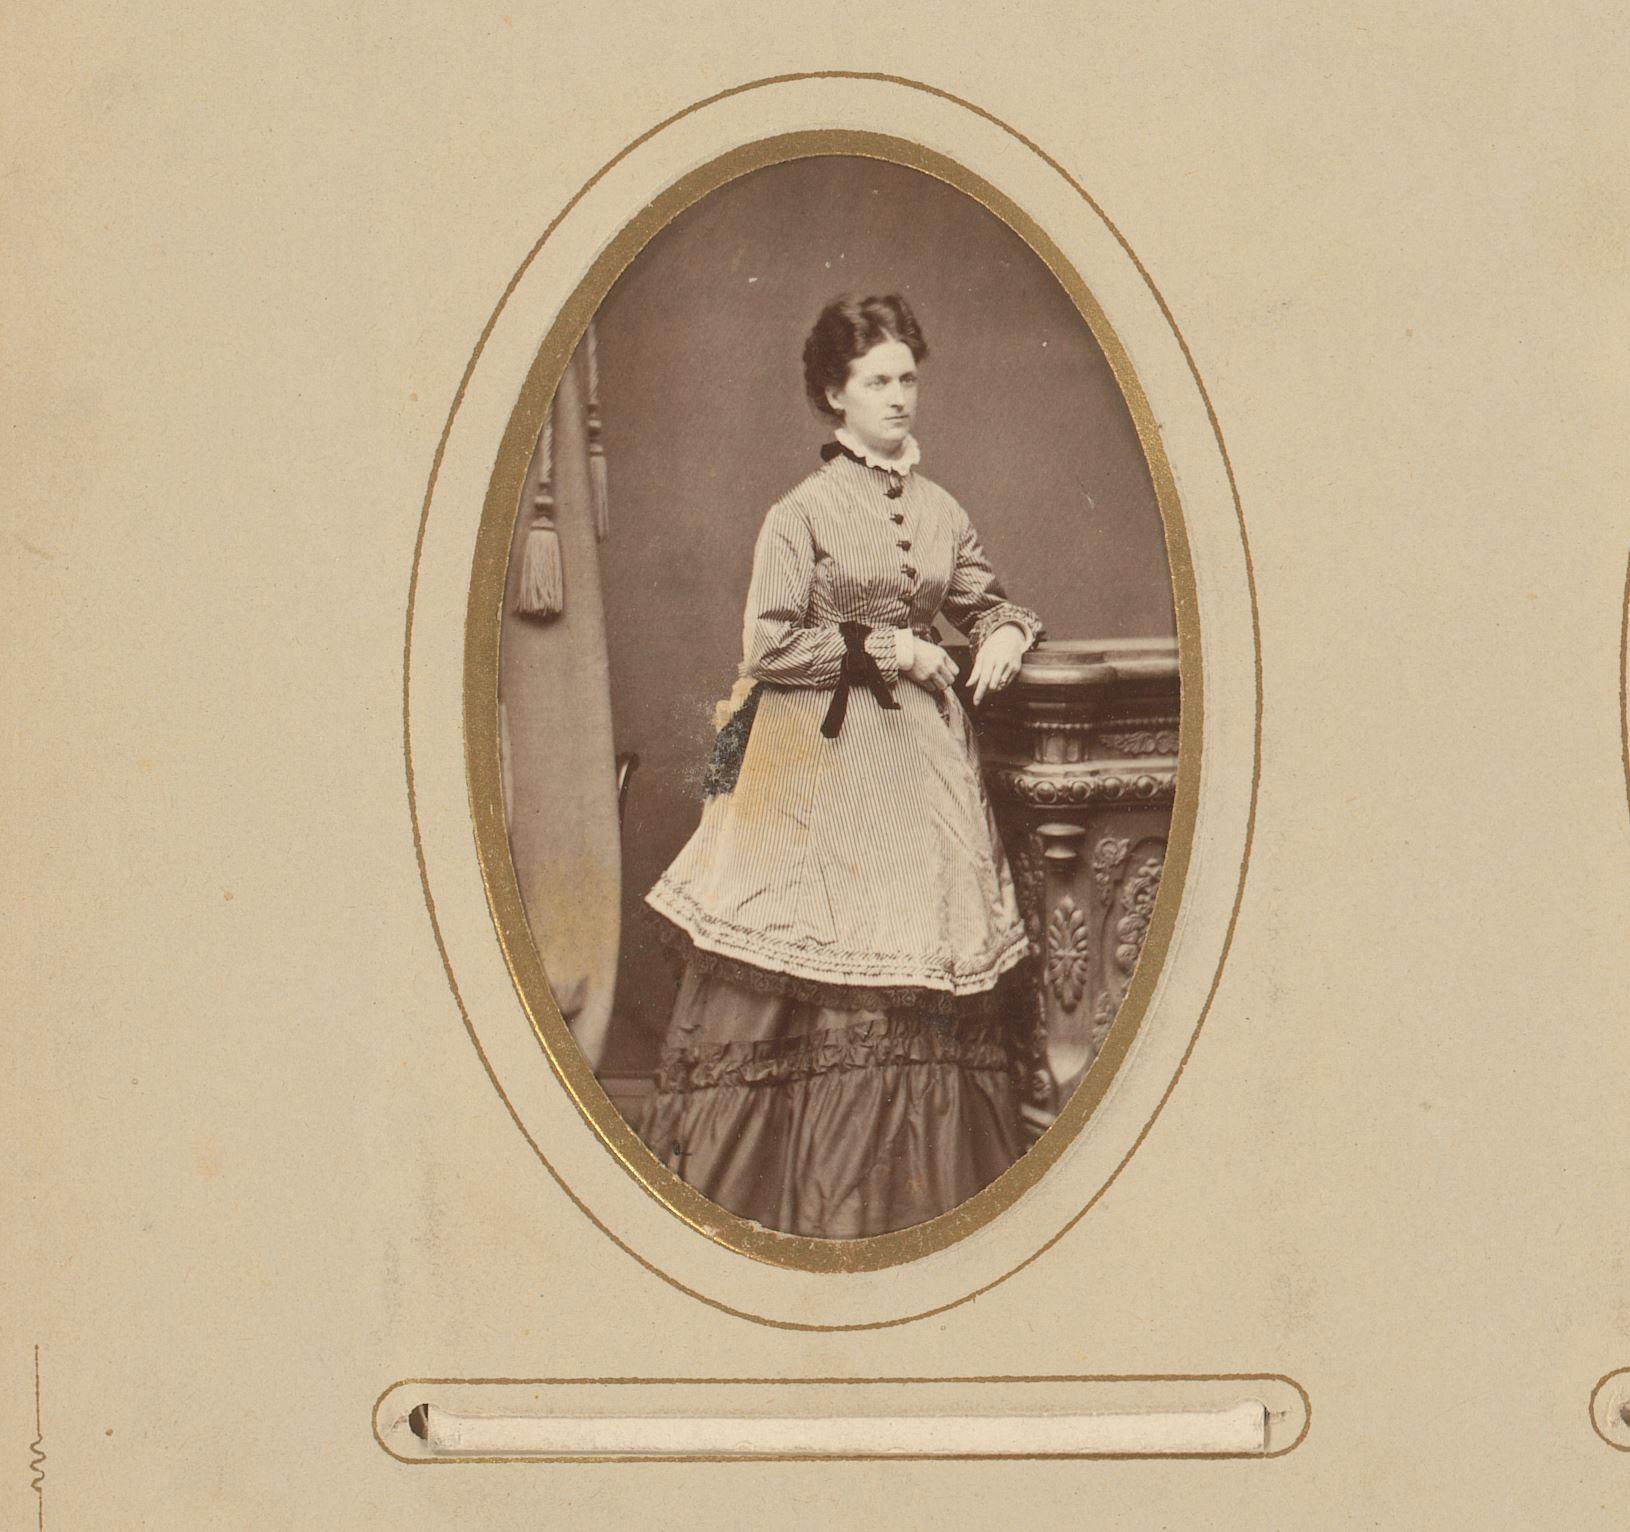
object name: photograph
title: Portret van een vrouw, leunend op een balustrade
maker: anton wiedling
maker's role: fotograaf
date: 1870-1900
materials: cardboard, photographic support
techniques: albumen print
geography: stolberg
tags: historical persons - bb - woman, balustrade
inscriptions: inscription: ‘Hochgräfl. Hofphotograph/ Anton Wiedling/ STOLBERG a/H.’